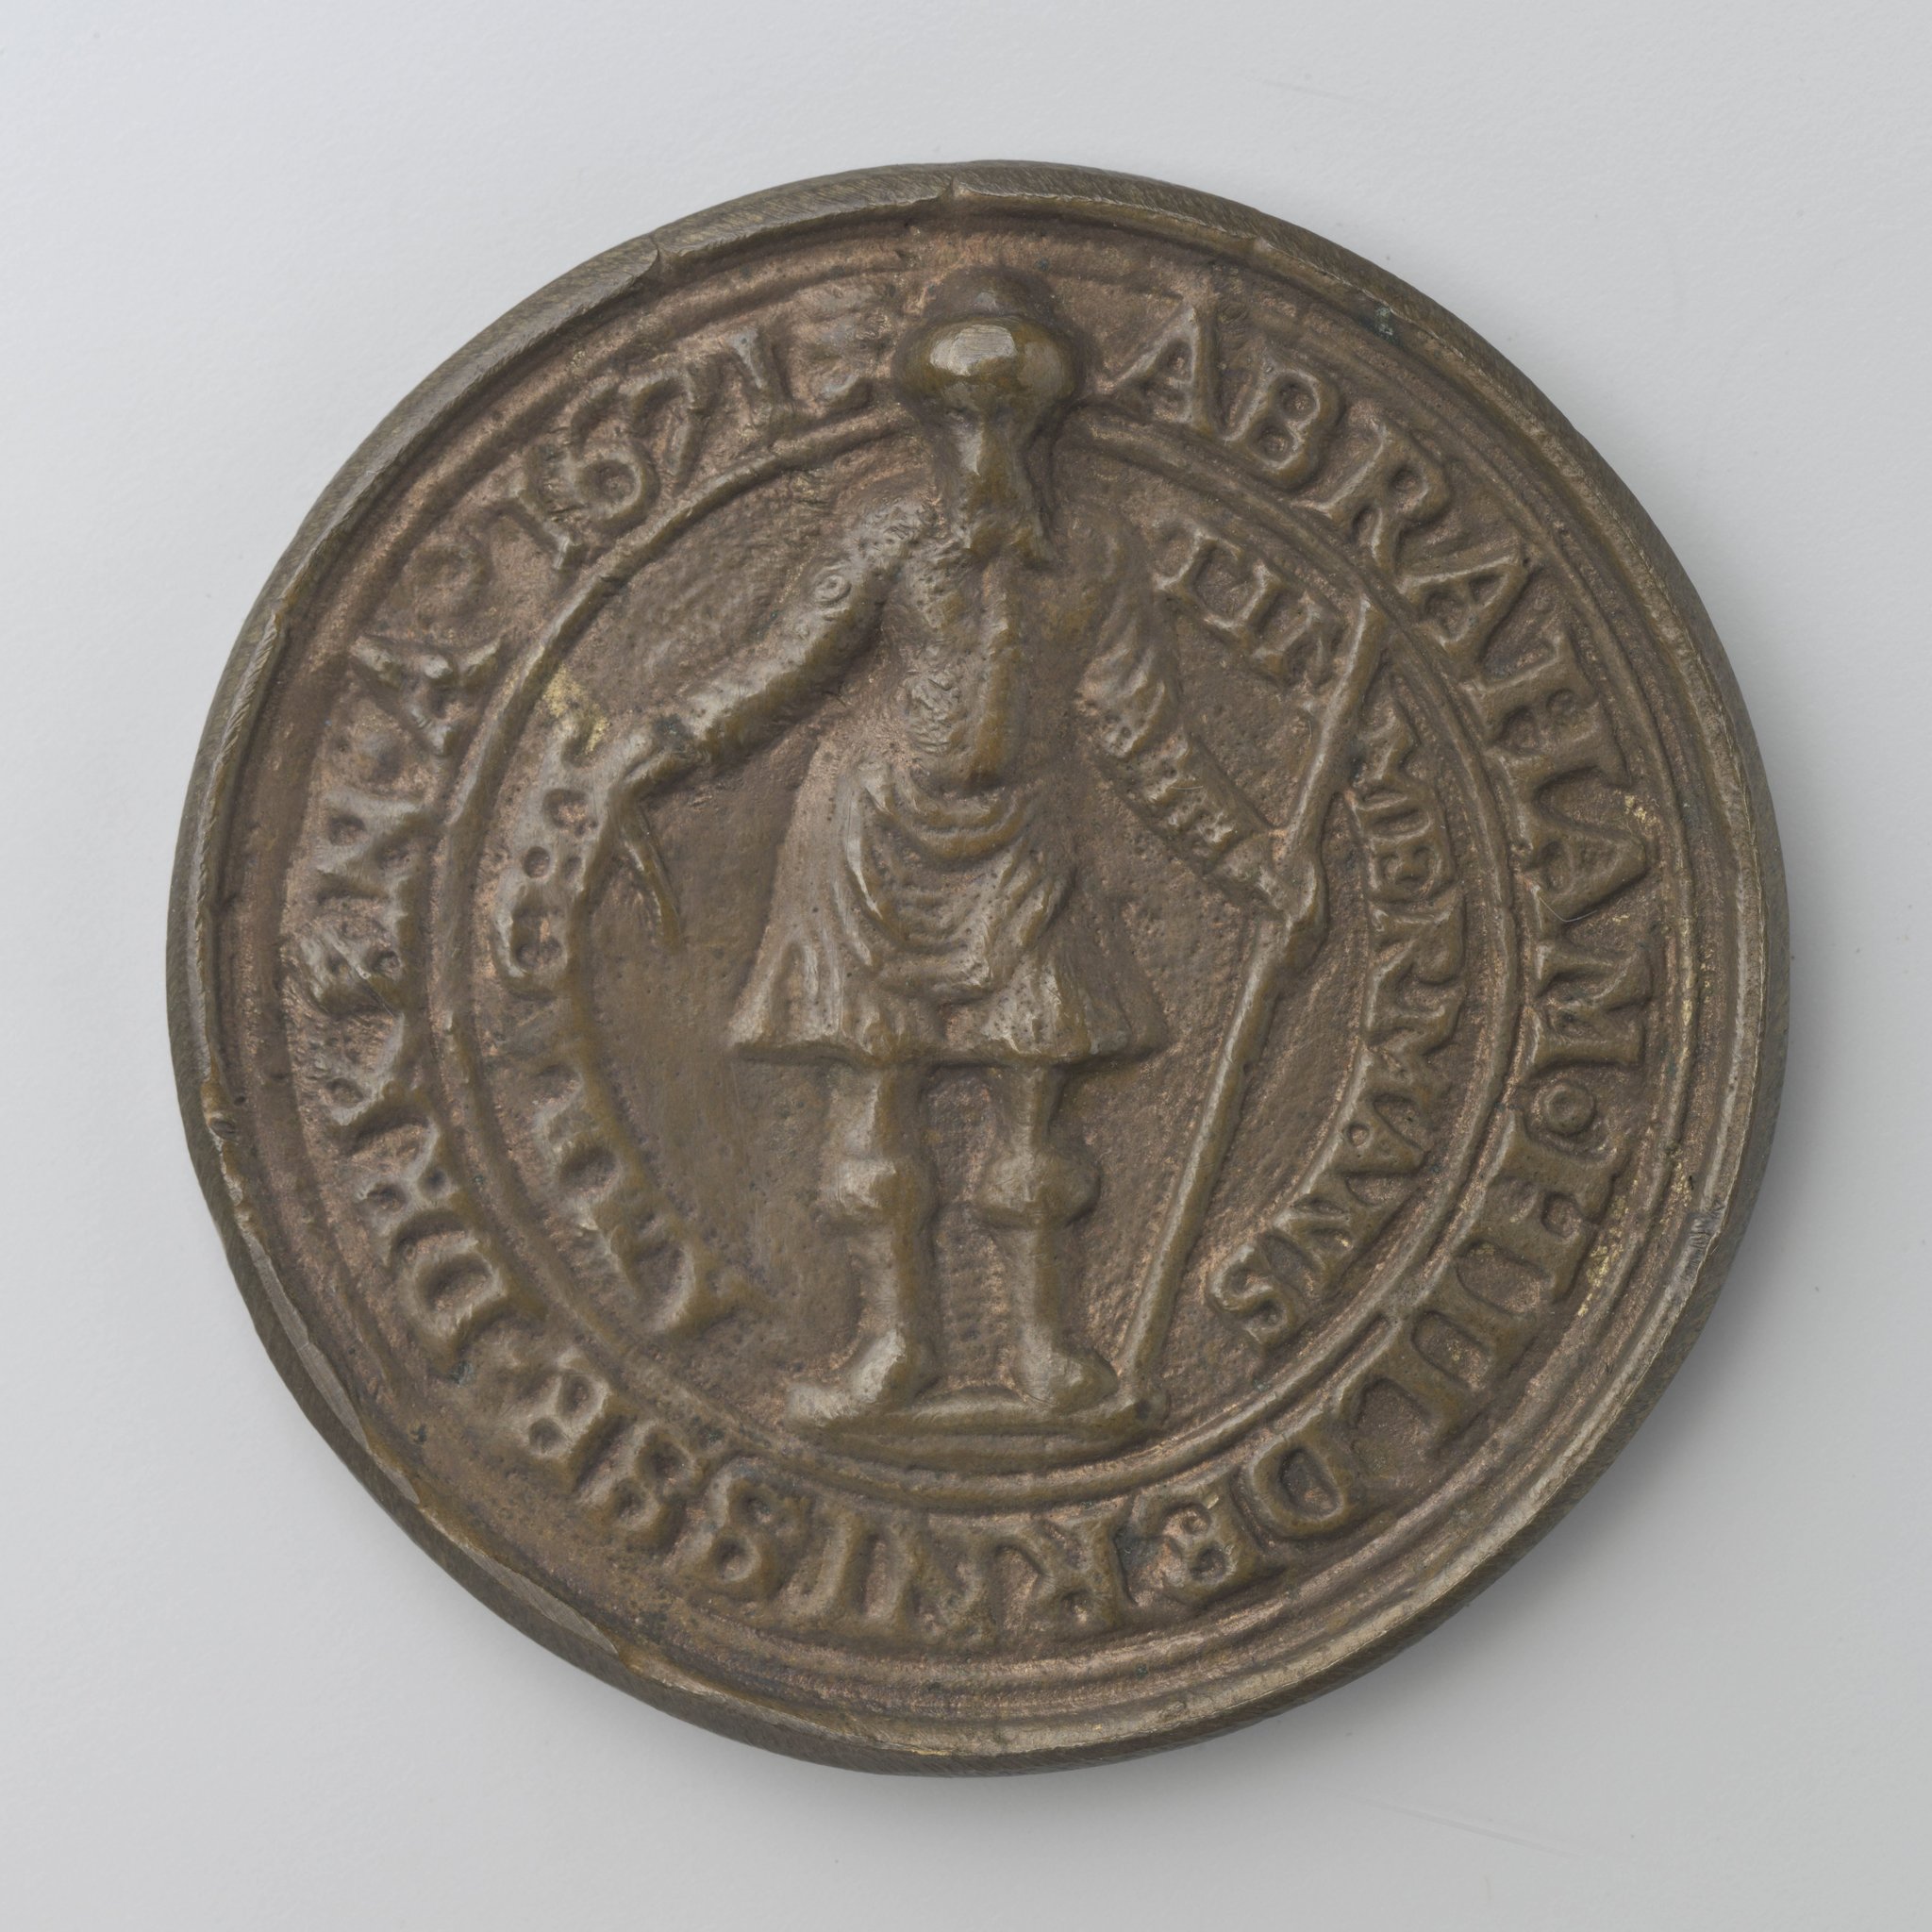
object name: medal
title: Timmerliedengilde van Middelburg, gildepenning met no. 16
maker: willem de laet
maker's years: 1647-1709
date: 1671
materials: brass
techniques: casting, engraving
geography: middelburg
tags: middelburg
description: Messing penning. Voorzijde: St. Jozef met tulband op hoofd, staande op voetstuk; in rechterhand een geopende passer, in linkerhand een maatstok binnen tweeregelig omschrift. Keerzijde: boor, bijl, winkelhaak, zaag, paslood, passer en hamer boven cijfer 16 (vermoedelijk, slecht leesbaar) binnen omschrift